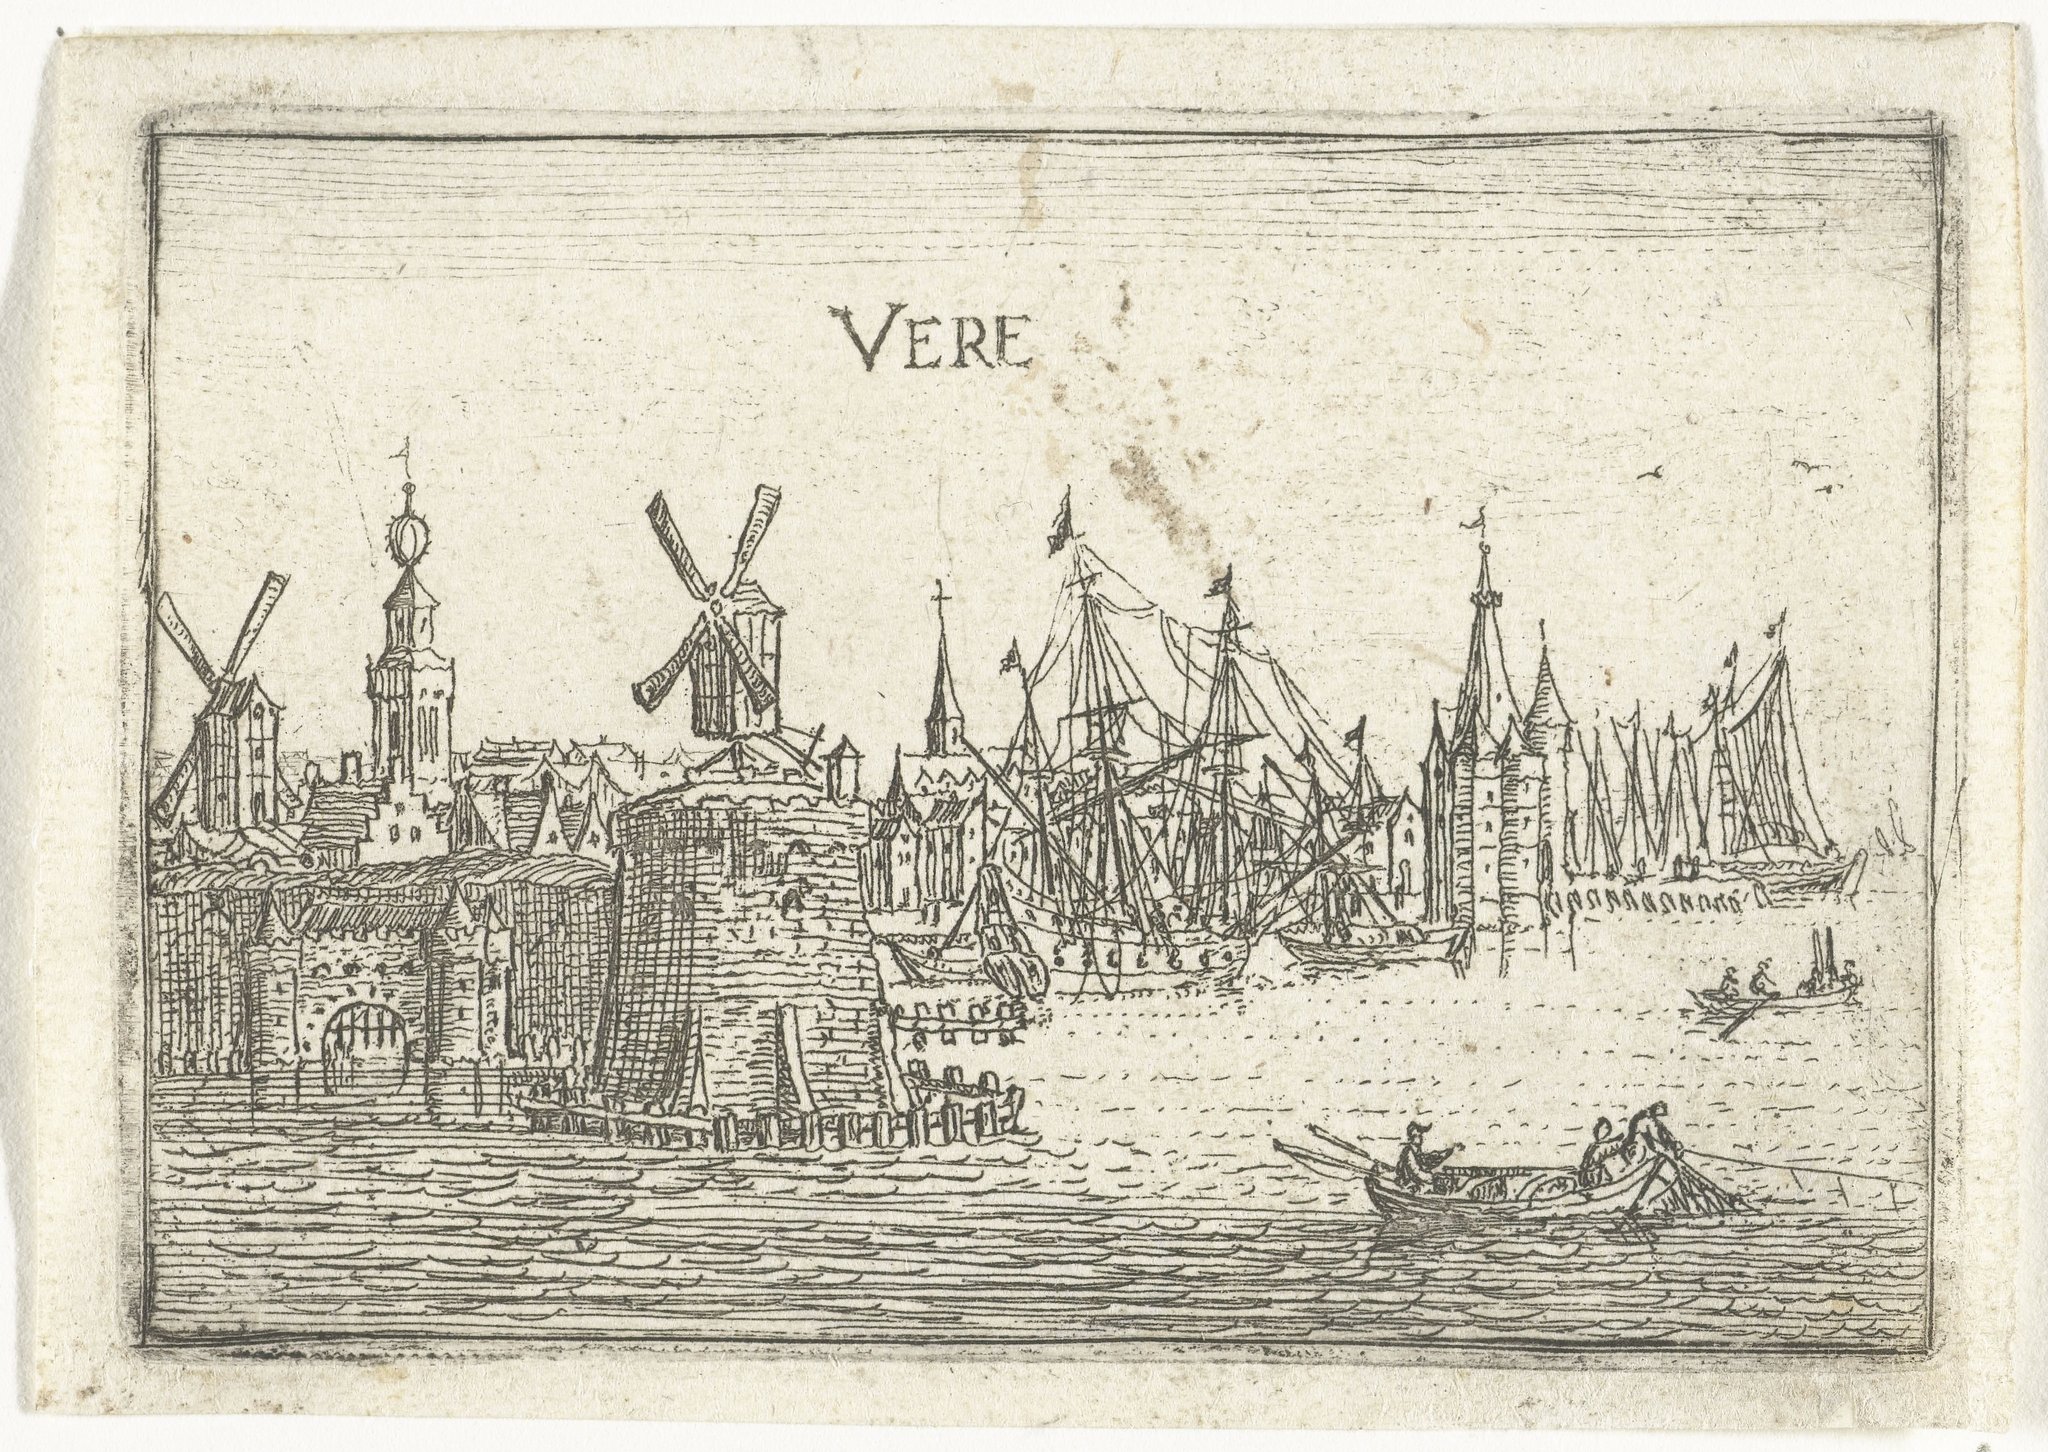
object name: print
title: Vere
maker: cornelis bol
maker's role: print maker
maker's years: 1589-1666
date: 1615-1666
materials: paper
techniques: etching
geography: netherlands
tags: city-view in general; 'veduta'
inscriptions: collector's mark: Lugt 2228